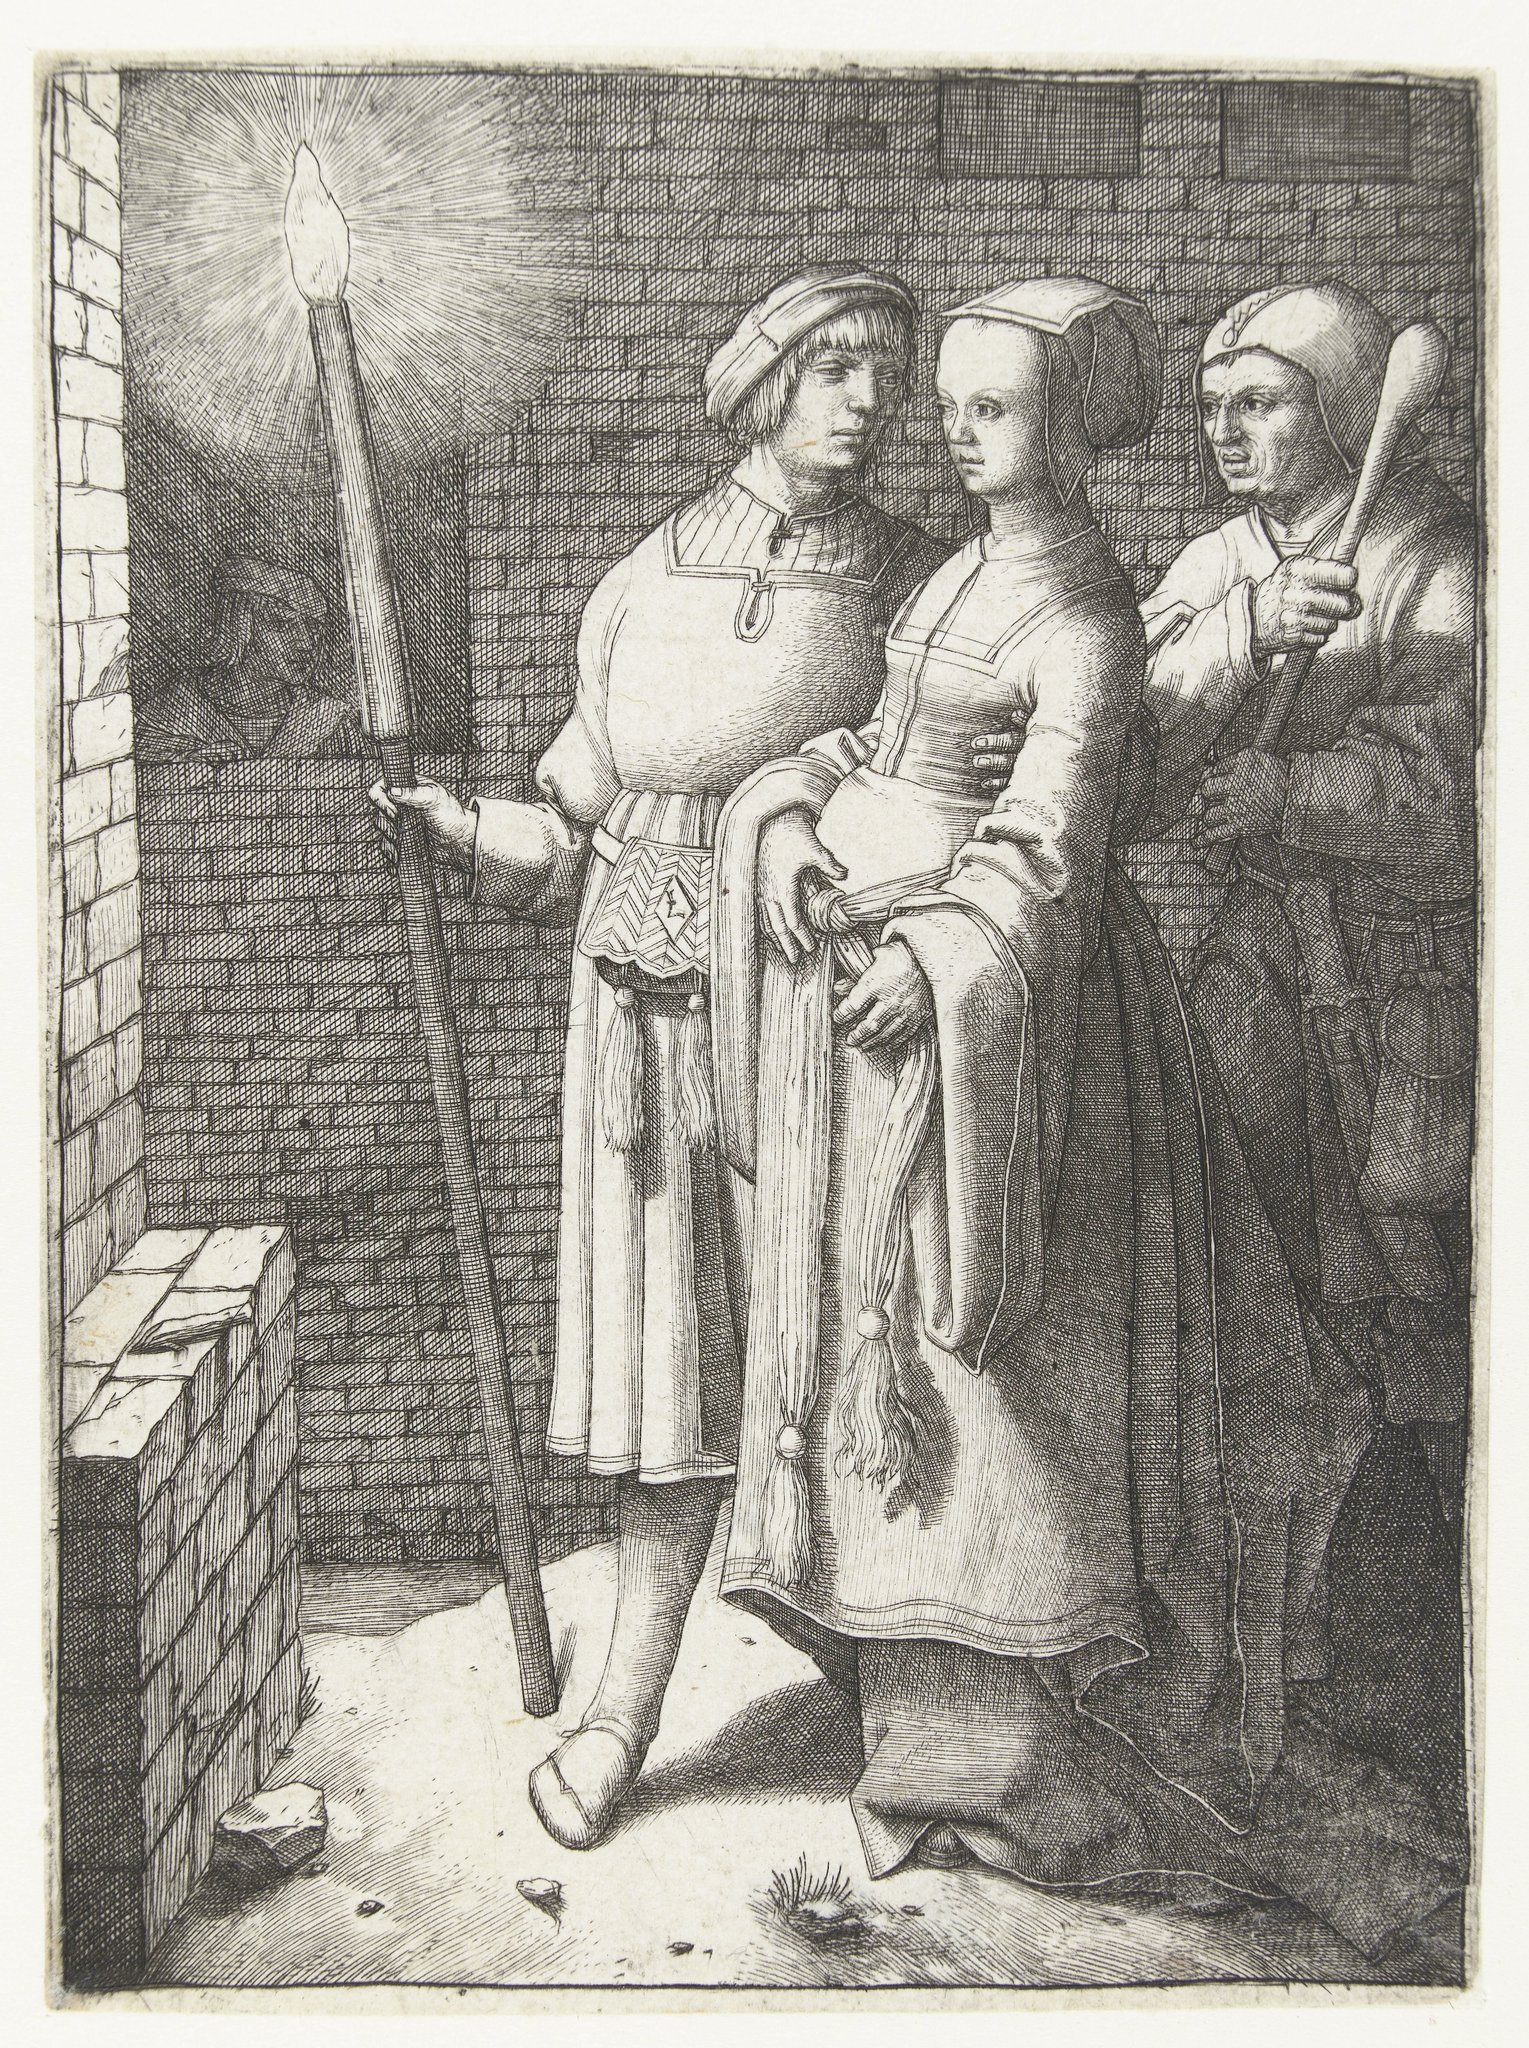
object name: print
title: Jongeman met een toorts, een vrouw en een nar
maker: lucas van leyden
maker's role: draughtsman, painter, print maker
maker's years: 1494-1533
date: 1506-1510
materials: paper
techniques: engraving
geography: low countries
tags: torch, court jester, court fool, head-gear (bonnet) (+ men's clothes), head-gear: cap (+ women's clothes), dress, gown (+ women's clothes), shoes, sandals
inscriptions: collector's mark: Lugt 240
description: Man en vrouw zijn gekleed volgens de mode van ca. 1500-1510. De vrouw draagt een tabbaard* met vierkante halsuitsnijding en wijduitlopende mouwen, een geknoopte gordel om de buik. Op het hoofd een kapje met platgelegde sluier. De man draagt een paltrok* met vierkante hals, een muts met opgerolde rand (bonnet *) en koemuilen* aan de voeten. Ihle p. 12, nr. 24: Jongeman draagt bonnet met ingekeepte opgeslage rand. Paltrock met vierkante hals. Daarboven is een eenvoudig hemd zichtbaar. Om zijn schouder een tas. Vrouw draagt kostuum met wijde omgeslagen mouwen. Ze houdt de voorkant van de rok omhoog terwijl ze een tip van haar sleep achter in de taille heeft opgenomen. Lange zijden heupgordel (die men vaak bij LvL aantreft)